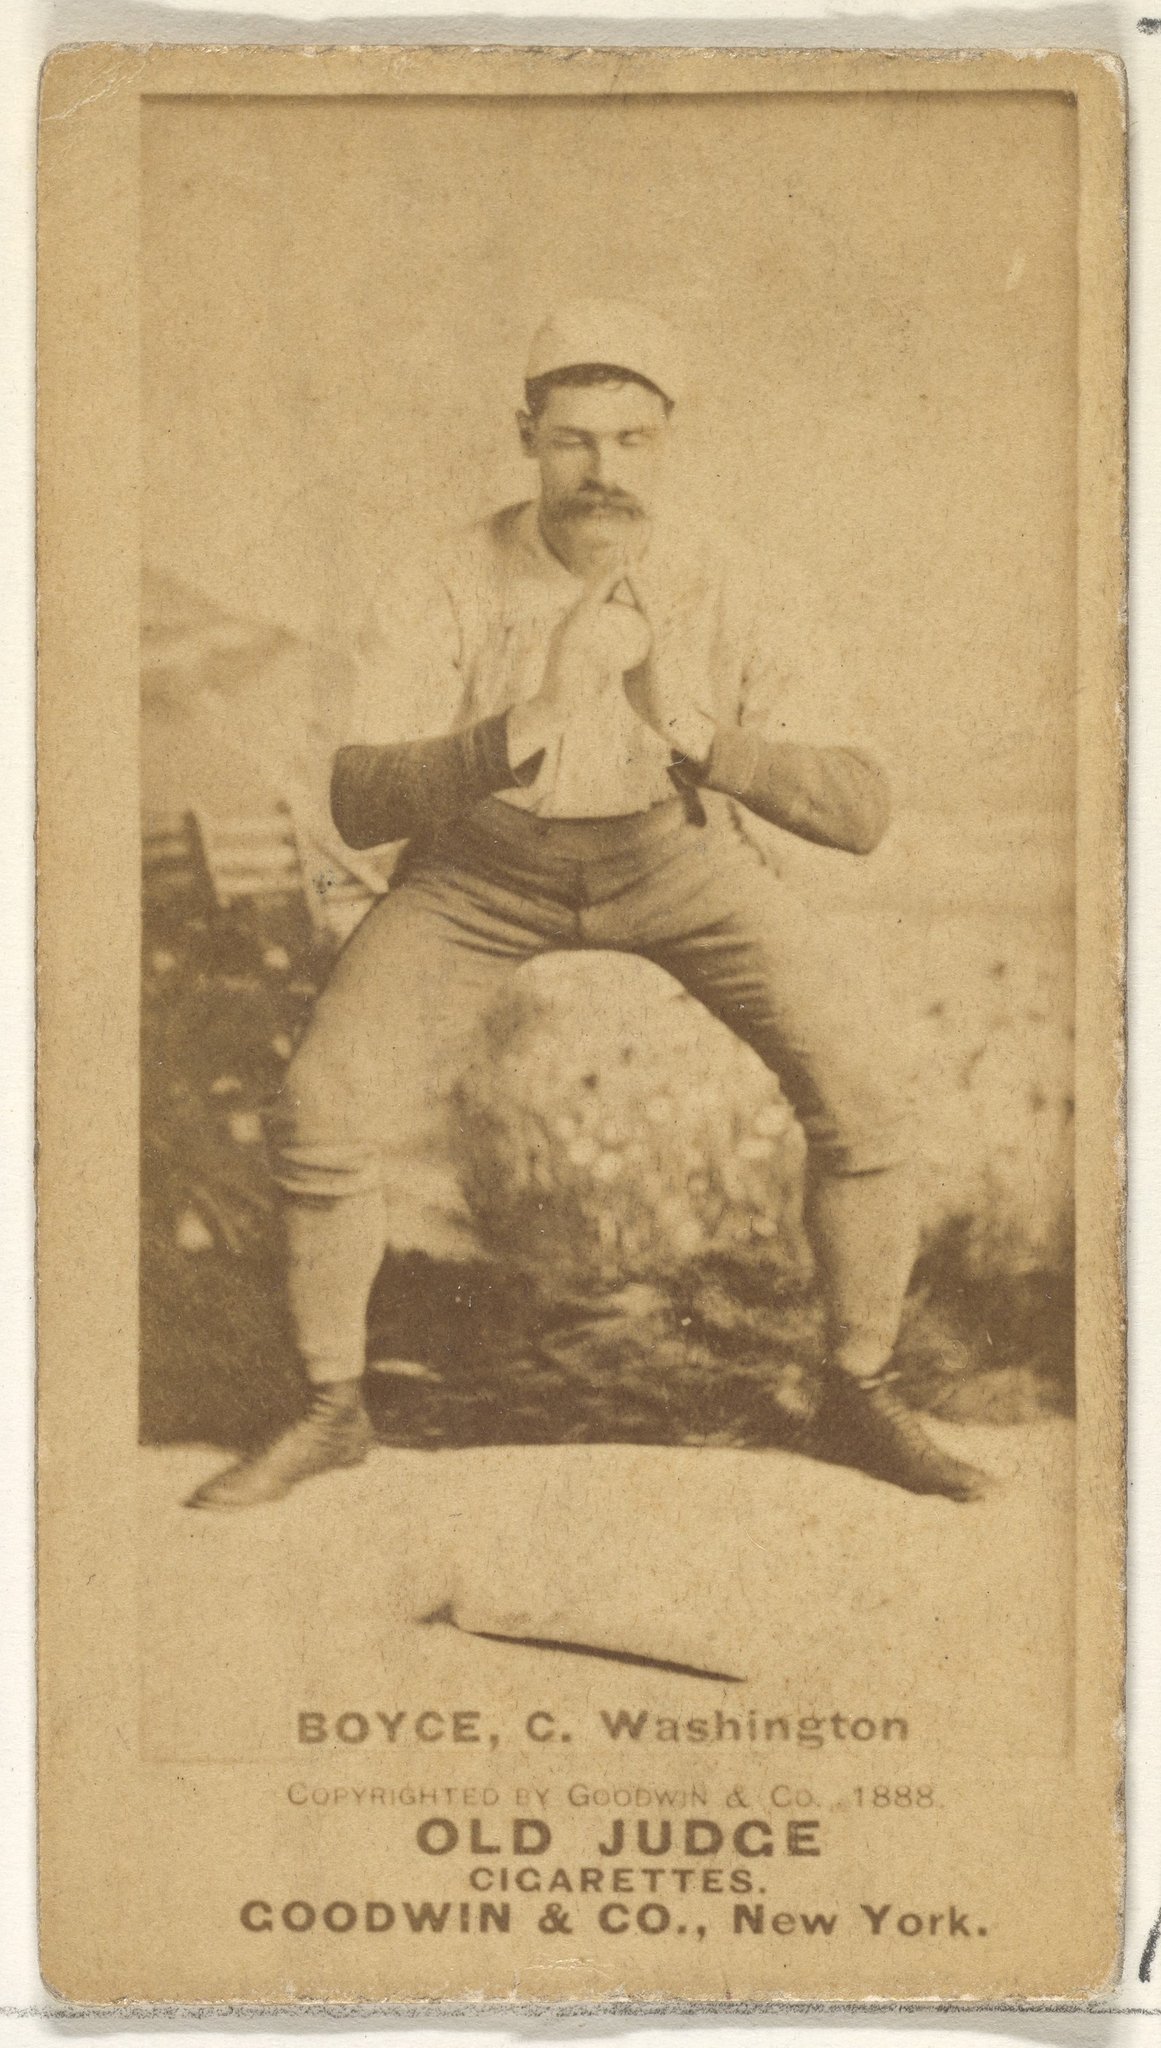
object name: baseball card, photograph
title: Boyce, Catcher, Washington, from the Old Judge series (N172) for Old Judge Cigarettes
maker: goodwin & company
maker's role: publisher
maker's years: 1850-1950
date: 1888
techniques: albumen silver print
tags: men,portraits,baseball,athletes